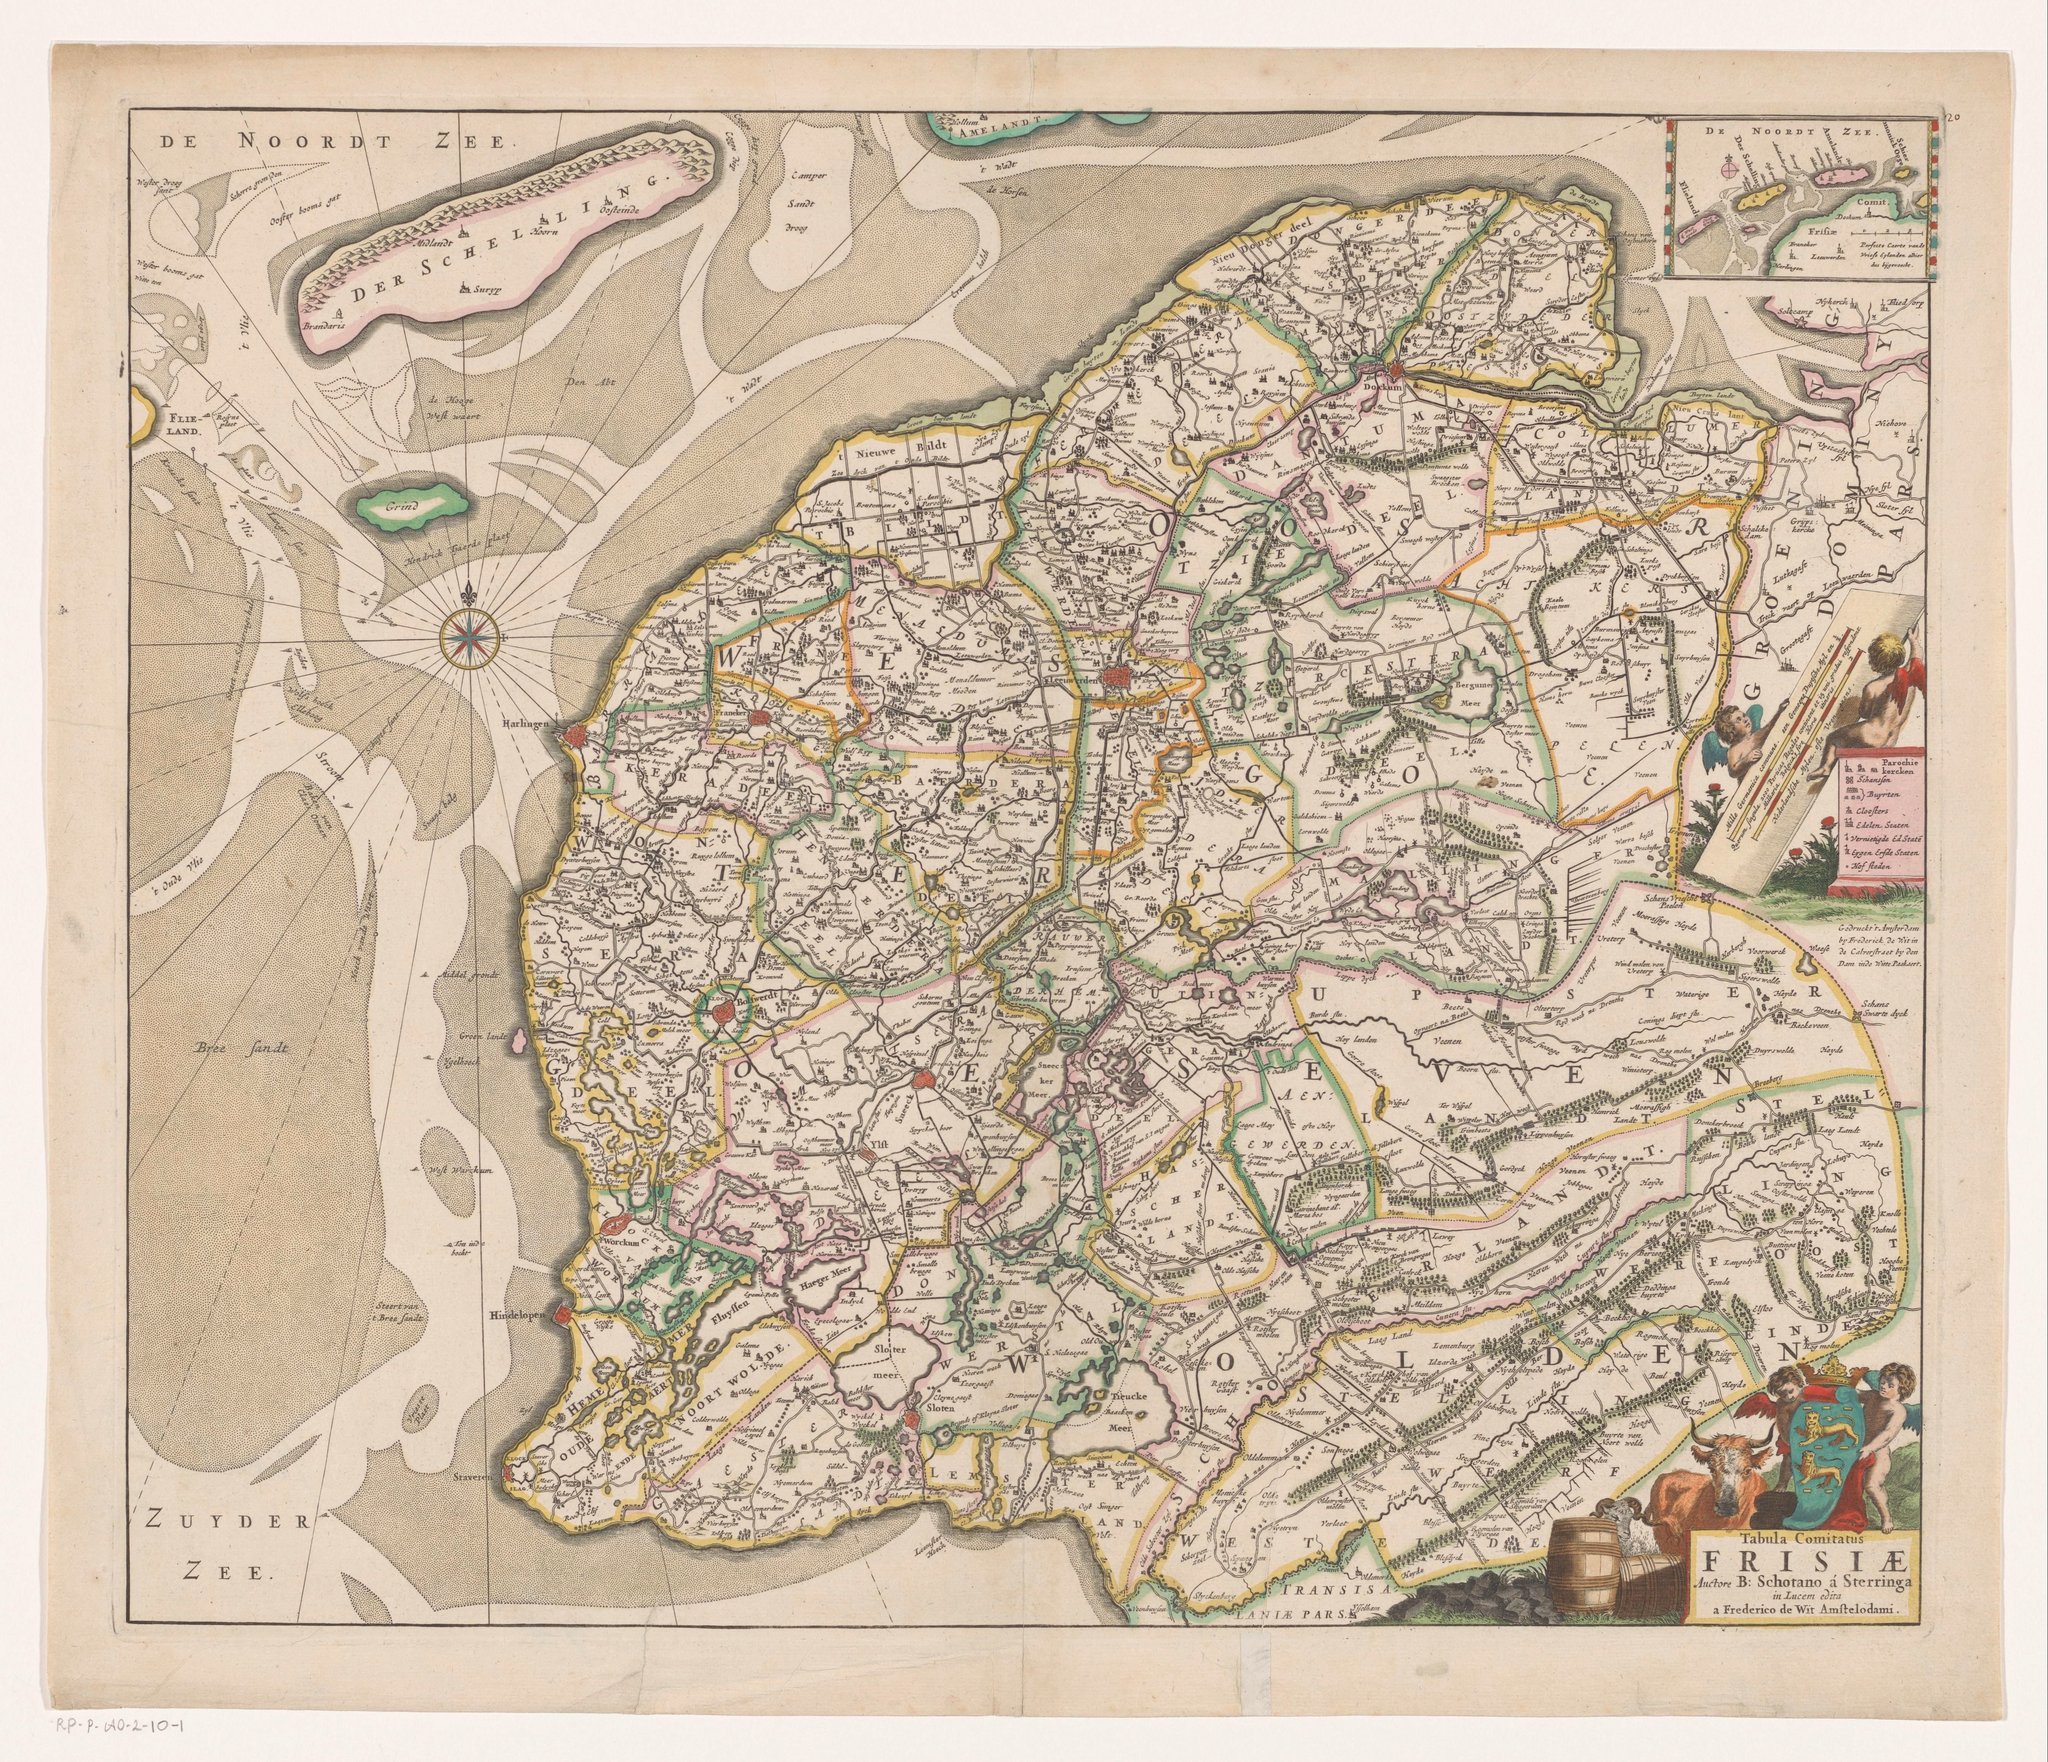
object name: print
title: Tabula comitatus Frisiae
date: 1665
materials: paper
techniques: engraving, hand coloring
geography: amsterdam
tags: coat of arms (as symbol of the state, etc.), maps of separate countries or regions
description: Rechtsboven inzetkaart met Vlieland, Terschelling, Ameland en Schiermonnikoog. Rechts in het midden twee putti met legenda en twee schaalstokken: Mille Germanica commune / een gemeene Duytsche myl en 0.5, Nederlandsche mylen ofte uren gaens. Rechtsonder titelcartouche met daarboven het wapen van Friesland.